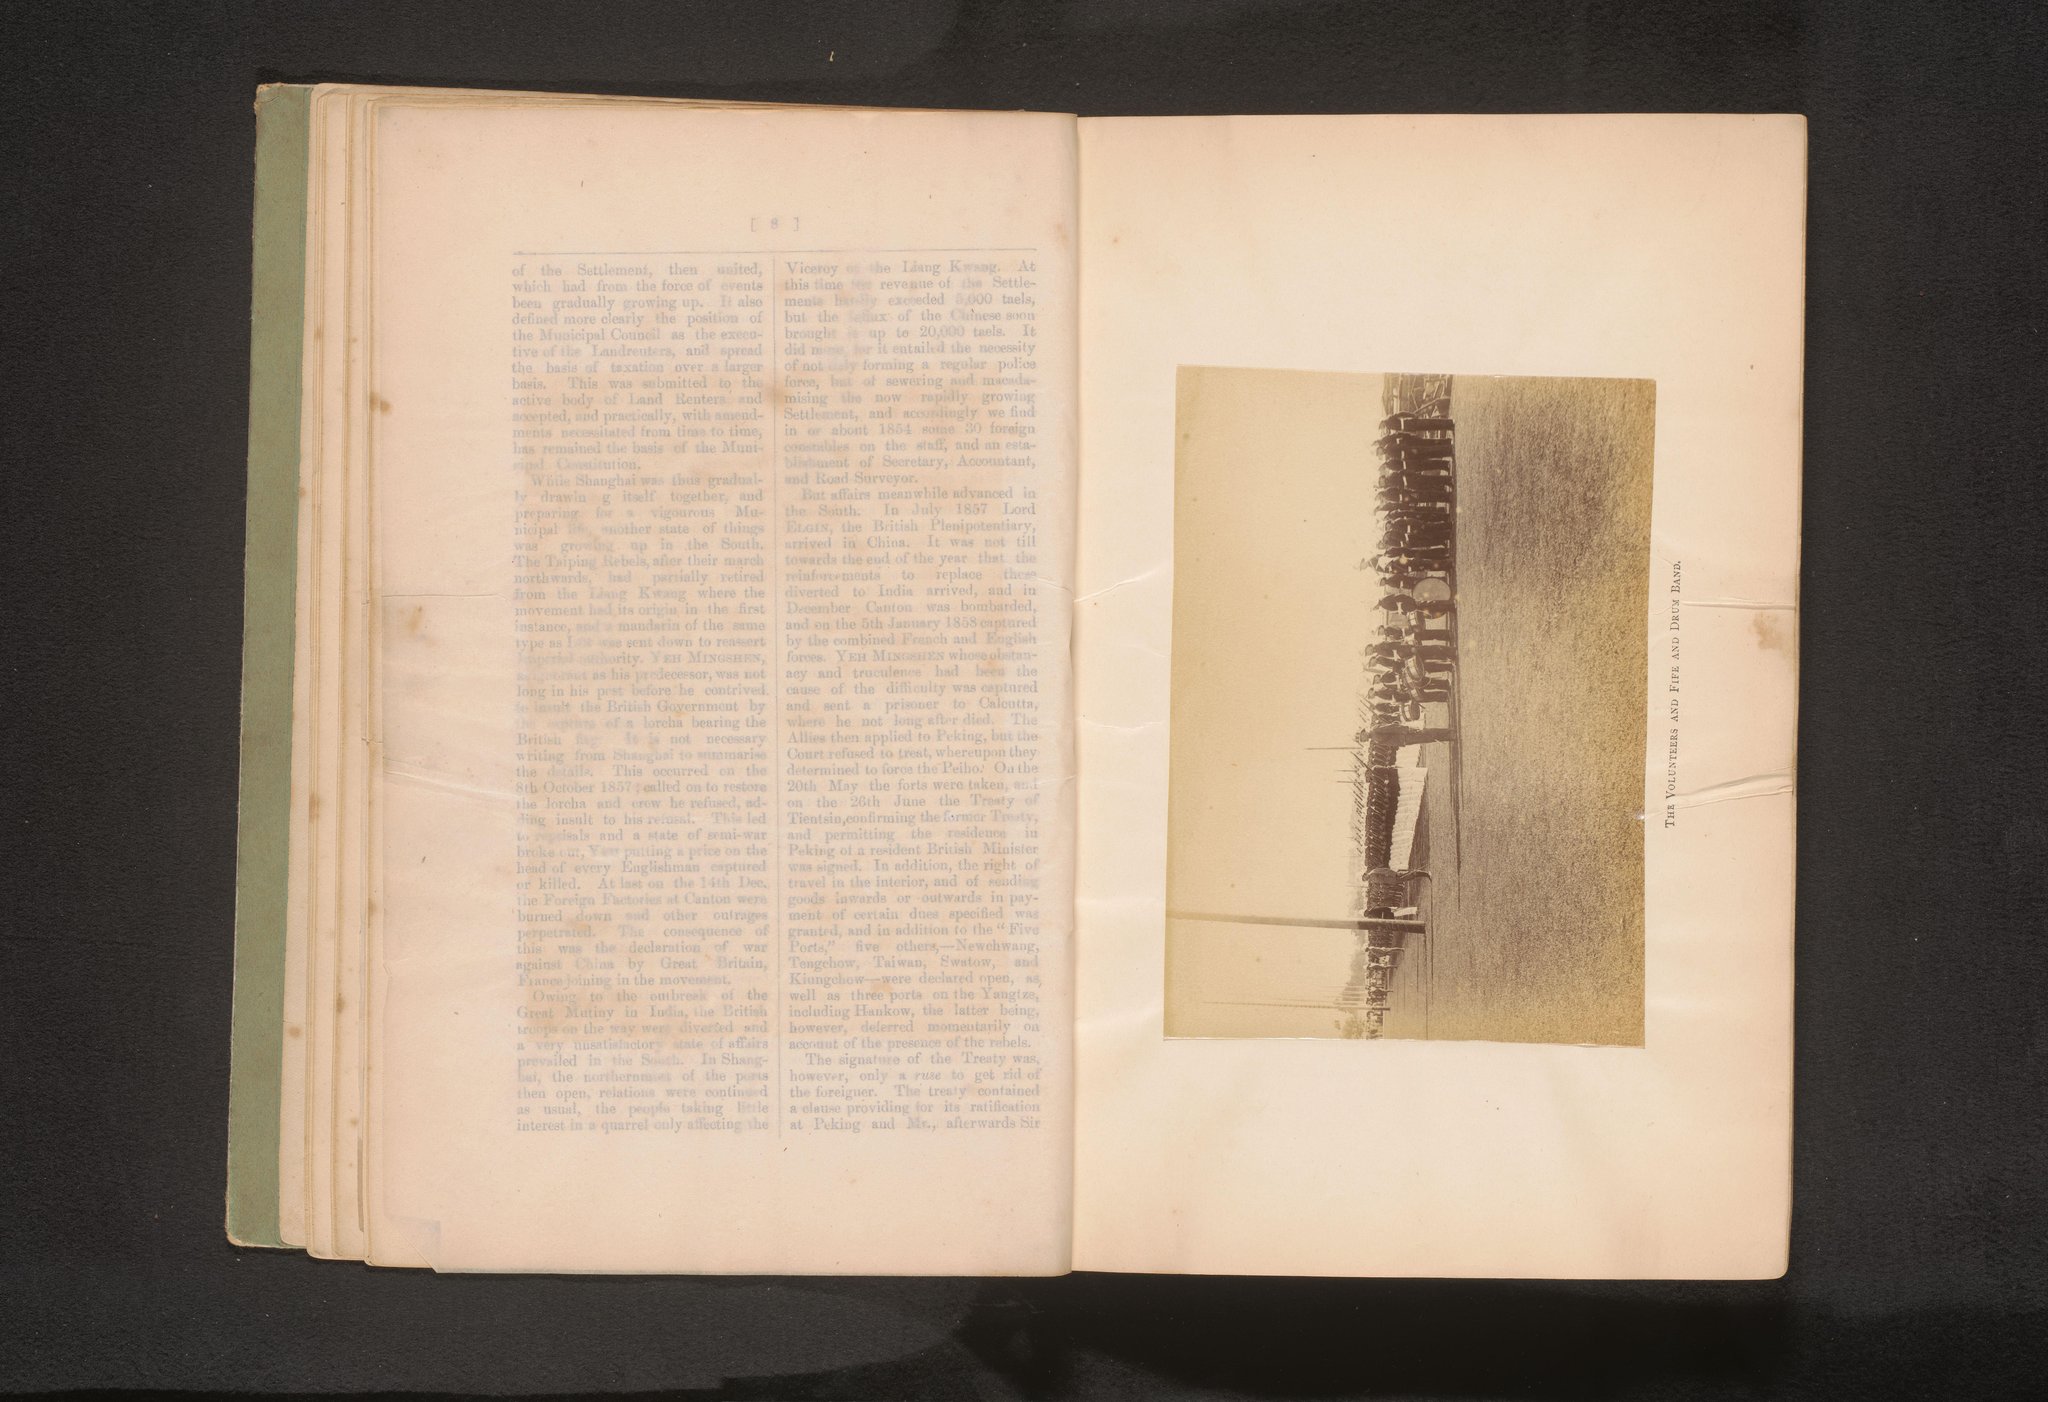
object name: photograph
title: Vrijwilligers en een drumband in Shanghai voor het diamanten jubileum van Victoria van het Verenigd Koninkrijk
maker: w.r. kahler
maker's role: fotograaf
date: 1897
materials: photographic support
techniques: albumen print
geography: shanghai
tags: drum (musical instrument), commemoration, jubilee